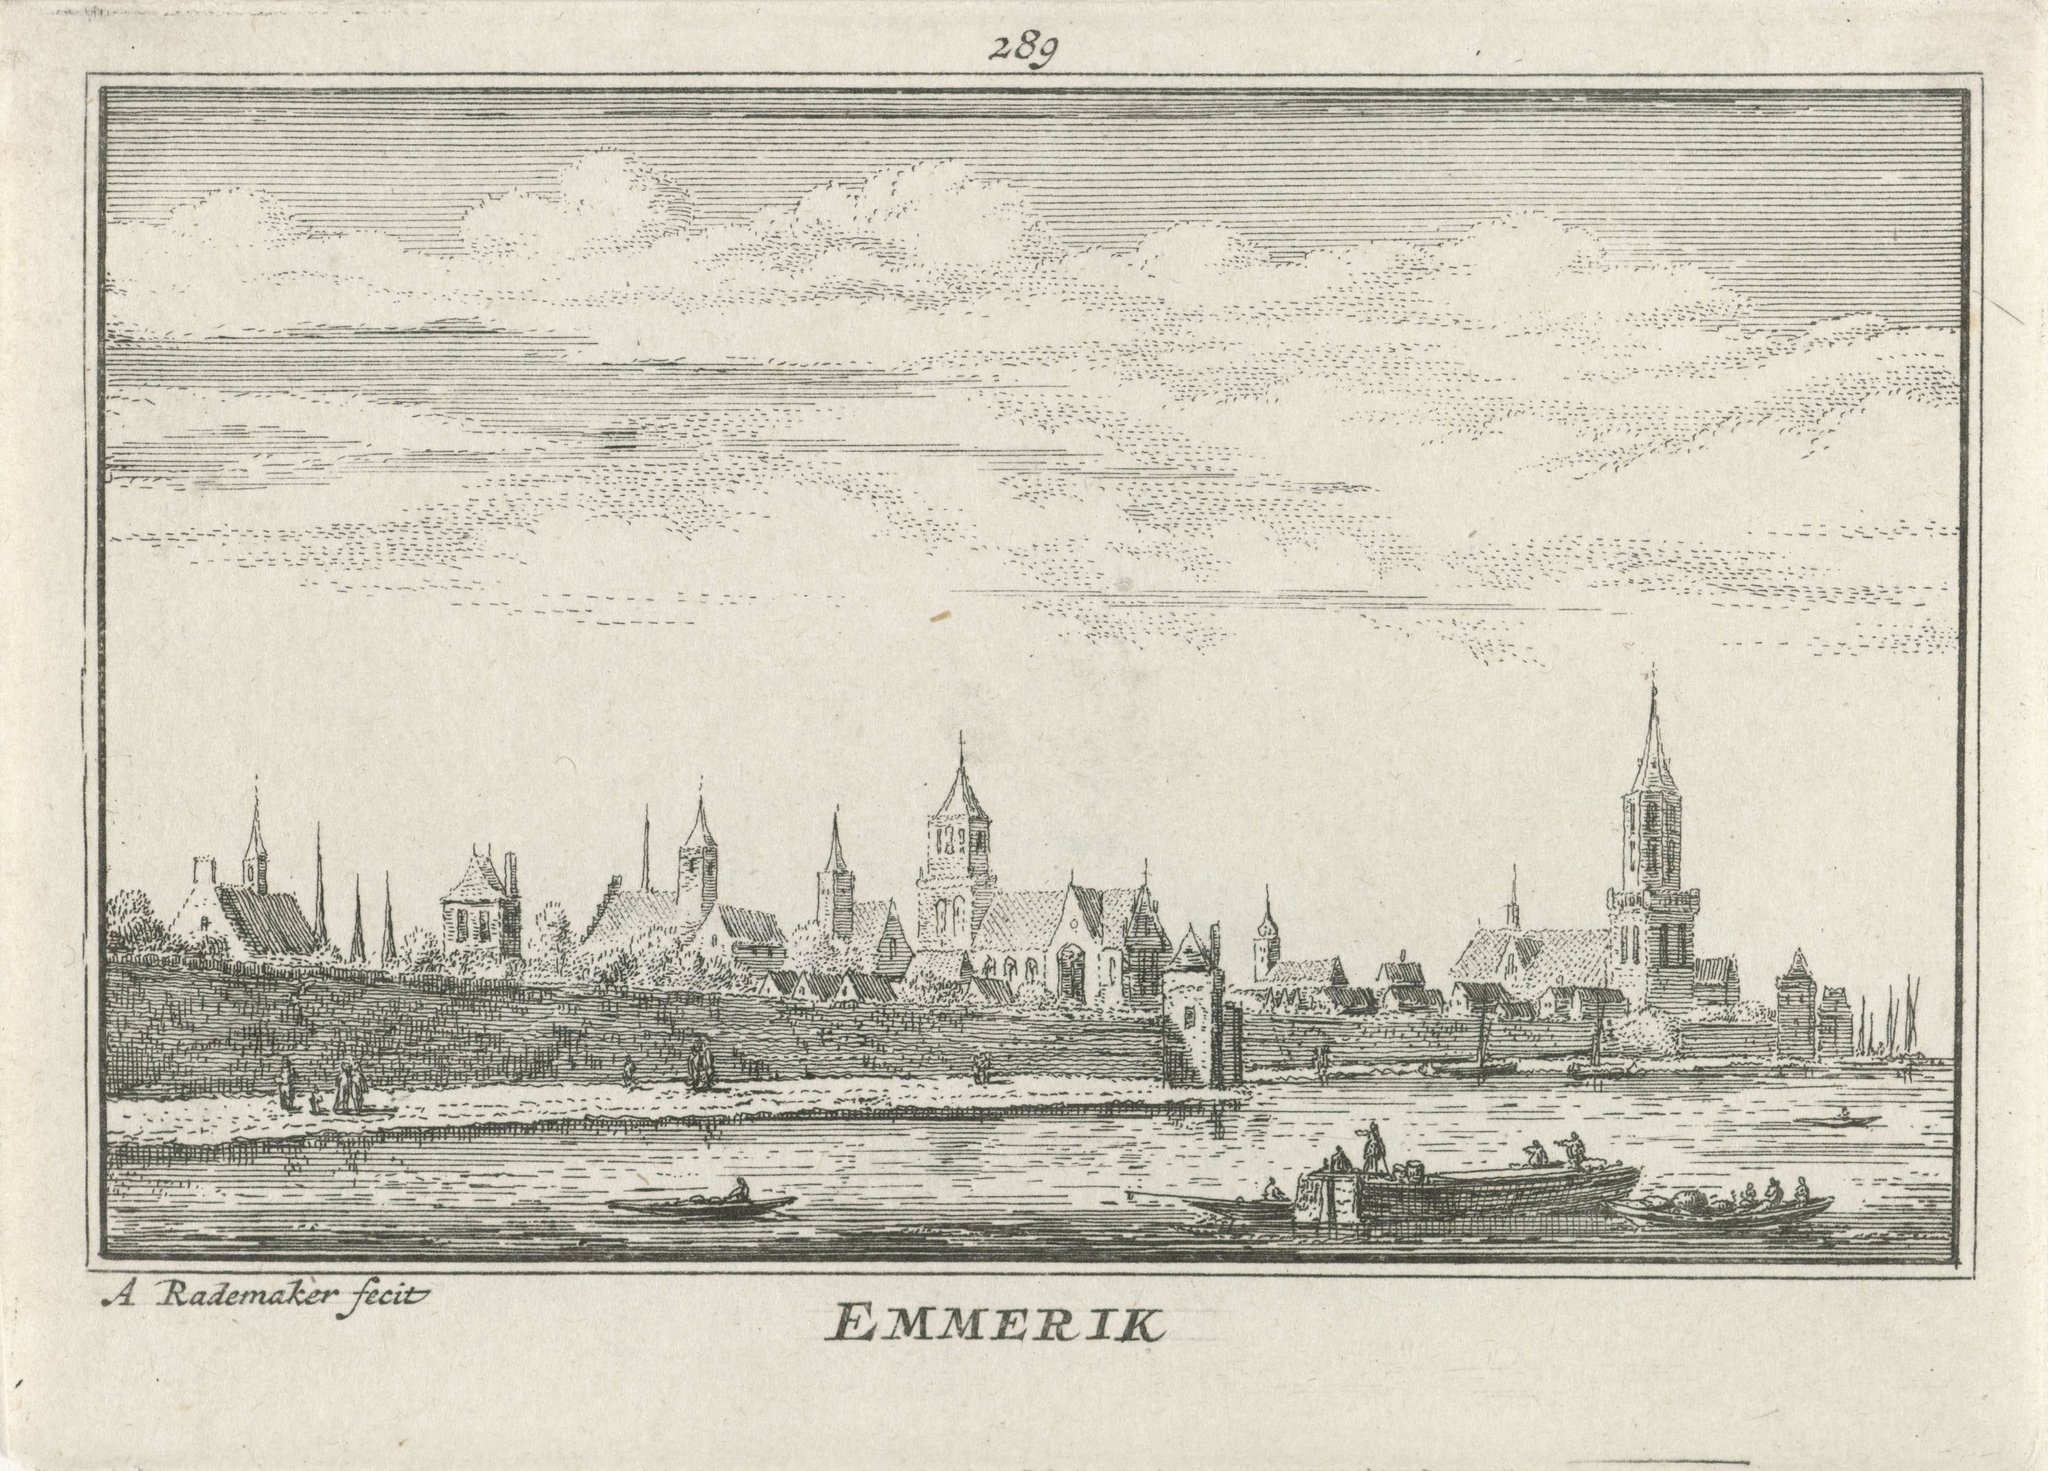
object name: print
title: Emmerik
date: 1727-1733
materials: paper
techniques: etching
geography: amsterdam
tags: church (exterior), rowing-boat, canoe, etc.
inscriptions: collector's mark: Lugt 2228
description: Illustratie uit: Abraham Rademaker, Matthaeus Brouërius van Niedek, Isaac Le Long, Kabinet van Nederlandsche en Kleefsche outheden en (...) voorname stads- en landgebouwen, Willem Barents en Antoni Schoonenburg: Amsterdam, 1727-1733, ill. nr. 289.